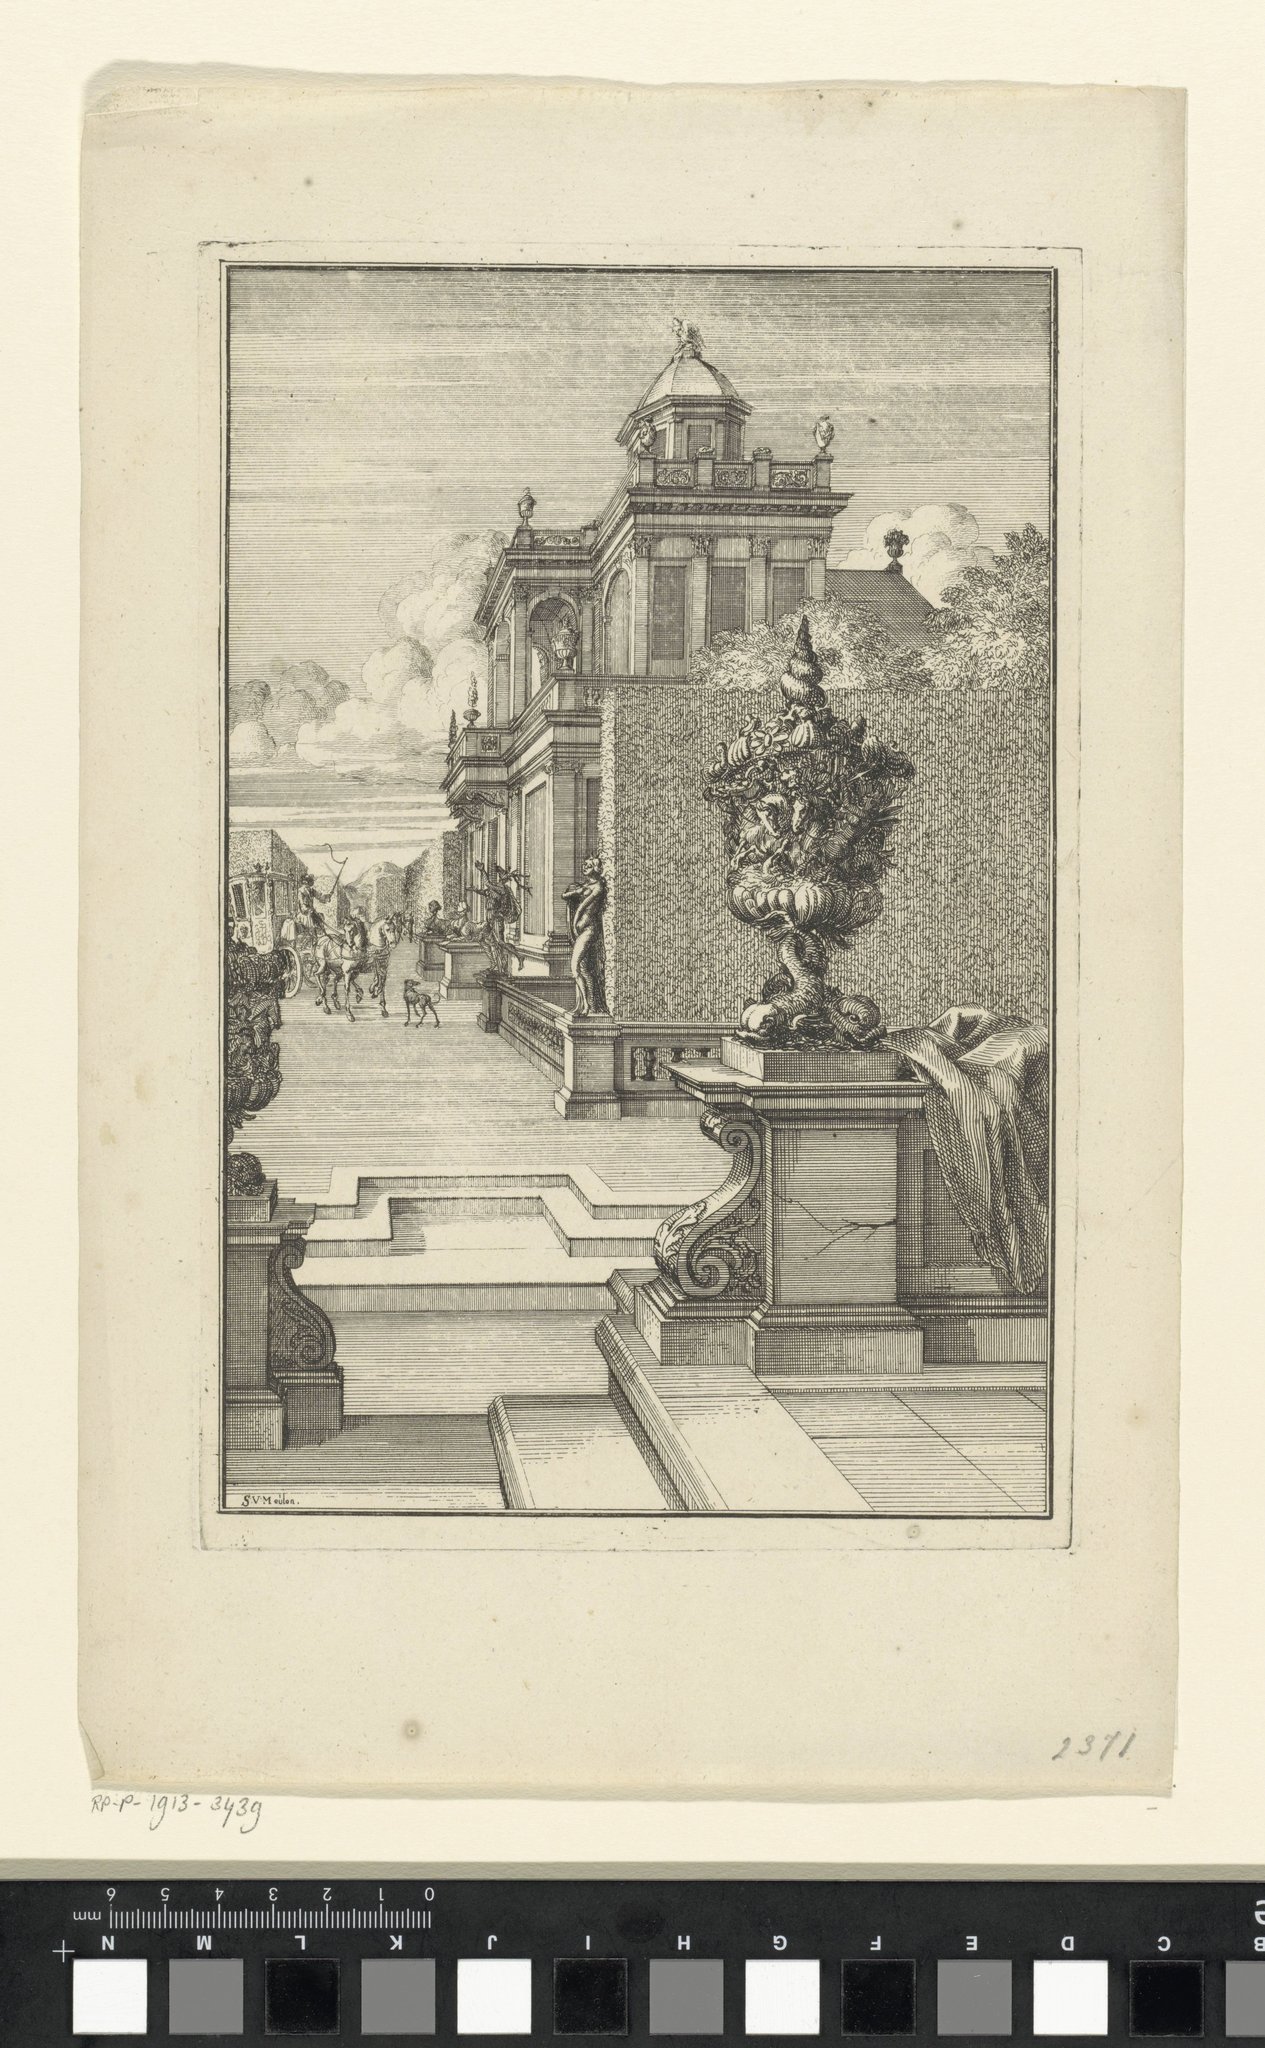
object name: print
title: Gesigten en Perspectiven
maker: sieuwert van der meulen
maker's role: draughtsman, print maker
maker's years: 1683-1730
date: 1707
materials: paper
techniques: etching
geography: netherlands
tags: french or architectonic garden; formal garden, garden vase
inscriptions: collector's mark: Lugt 2228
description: Op de voorgrond een ornamentele tuinvaas. Daarachter een gezicht in een laan met sculpturen en een gebouw rechts. In de laan een koets en een hond.